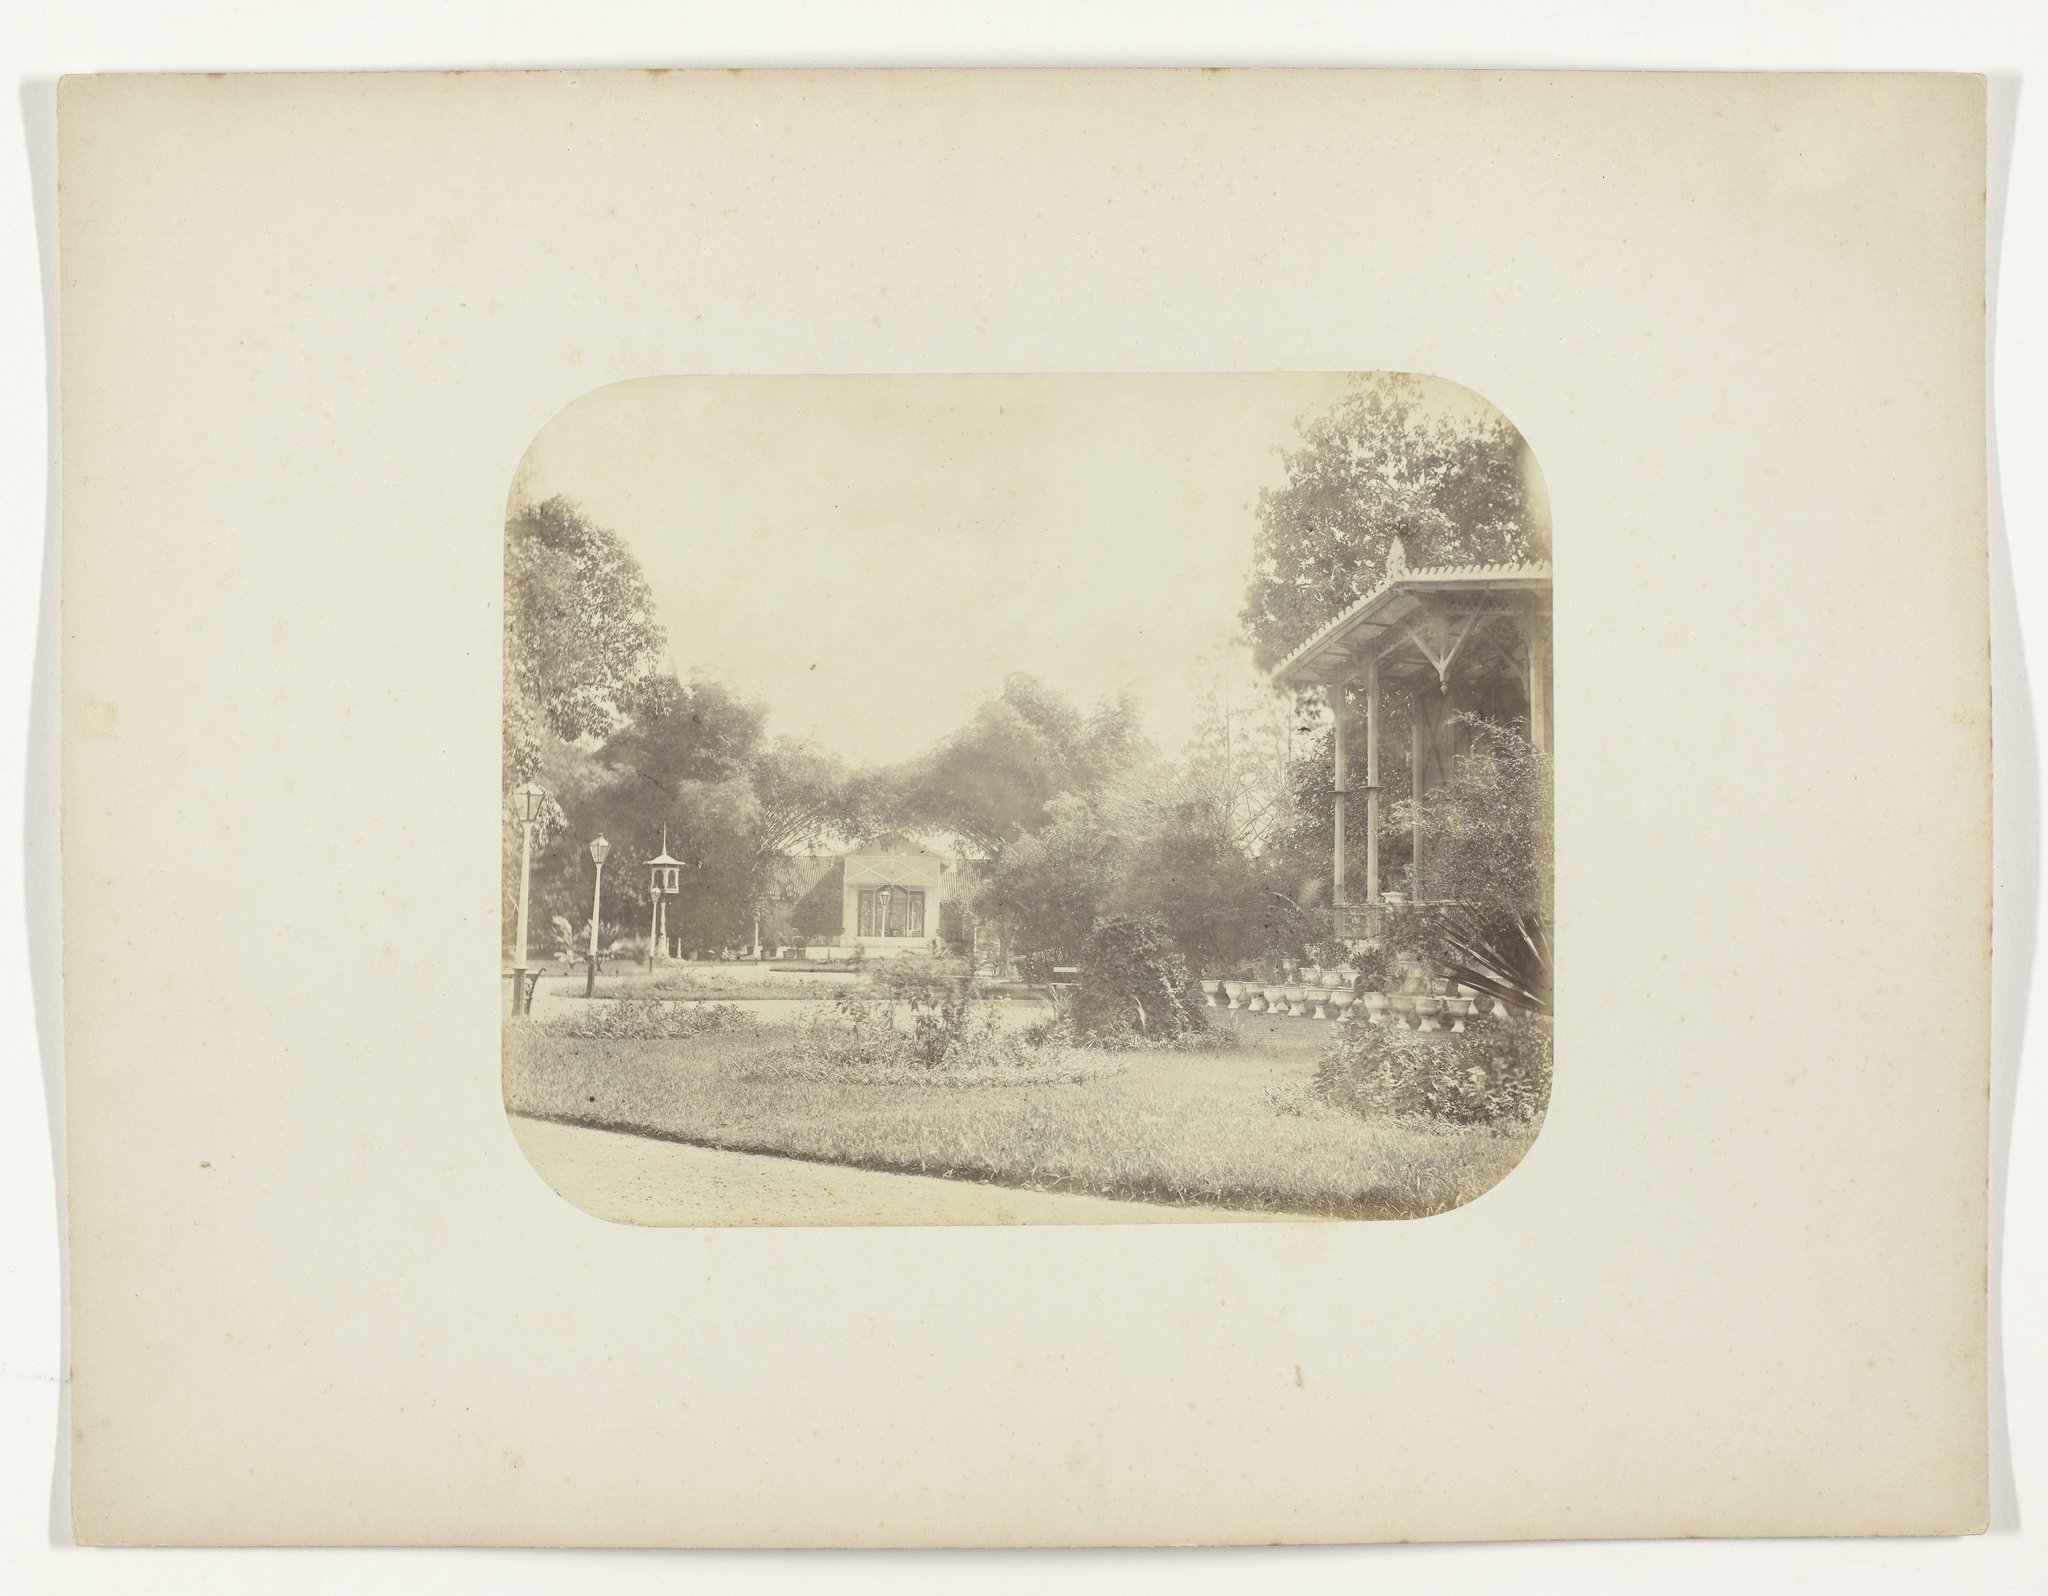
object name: photograph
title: Een kiosk in het stadspark van Surabaya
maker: herman salzwedel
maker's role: fotograaf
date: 1876-1884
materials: photographic support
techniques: albumen print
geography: surabaya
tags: utrecht, the hague, colonial system, public gardens, park, surabaya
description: Een kiosk in het stadspark van Surabaya uiterst rechts, ervoor vele bloempotten. Links een aantal lantaarnpalen en centraal de veranda van een huis. Onderdeel van het fotoalbum door de Soerabayasche Vereeniging van Suikerfabrikanten aangeboden aan Frederik Beyerinck, resident van Soerabaja.